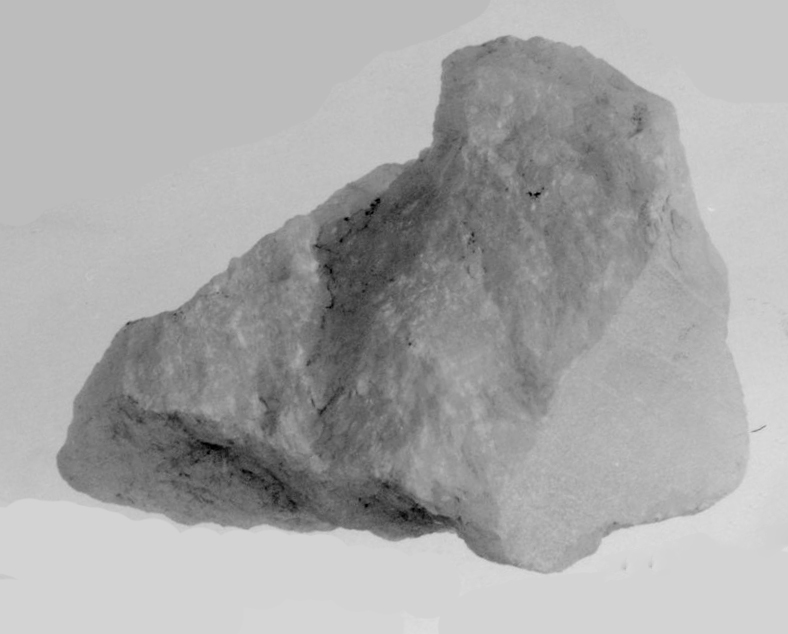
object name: canopic chest, tiye, thutmose iv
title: Fragment of a Canopic Chest of Queen Tiya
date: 1427-1390 BCE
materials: stone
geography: egypt